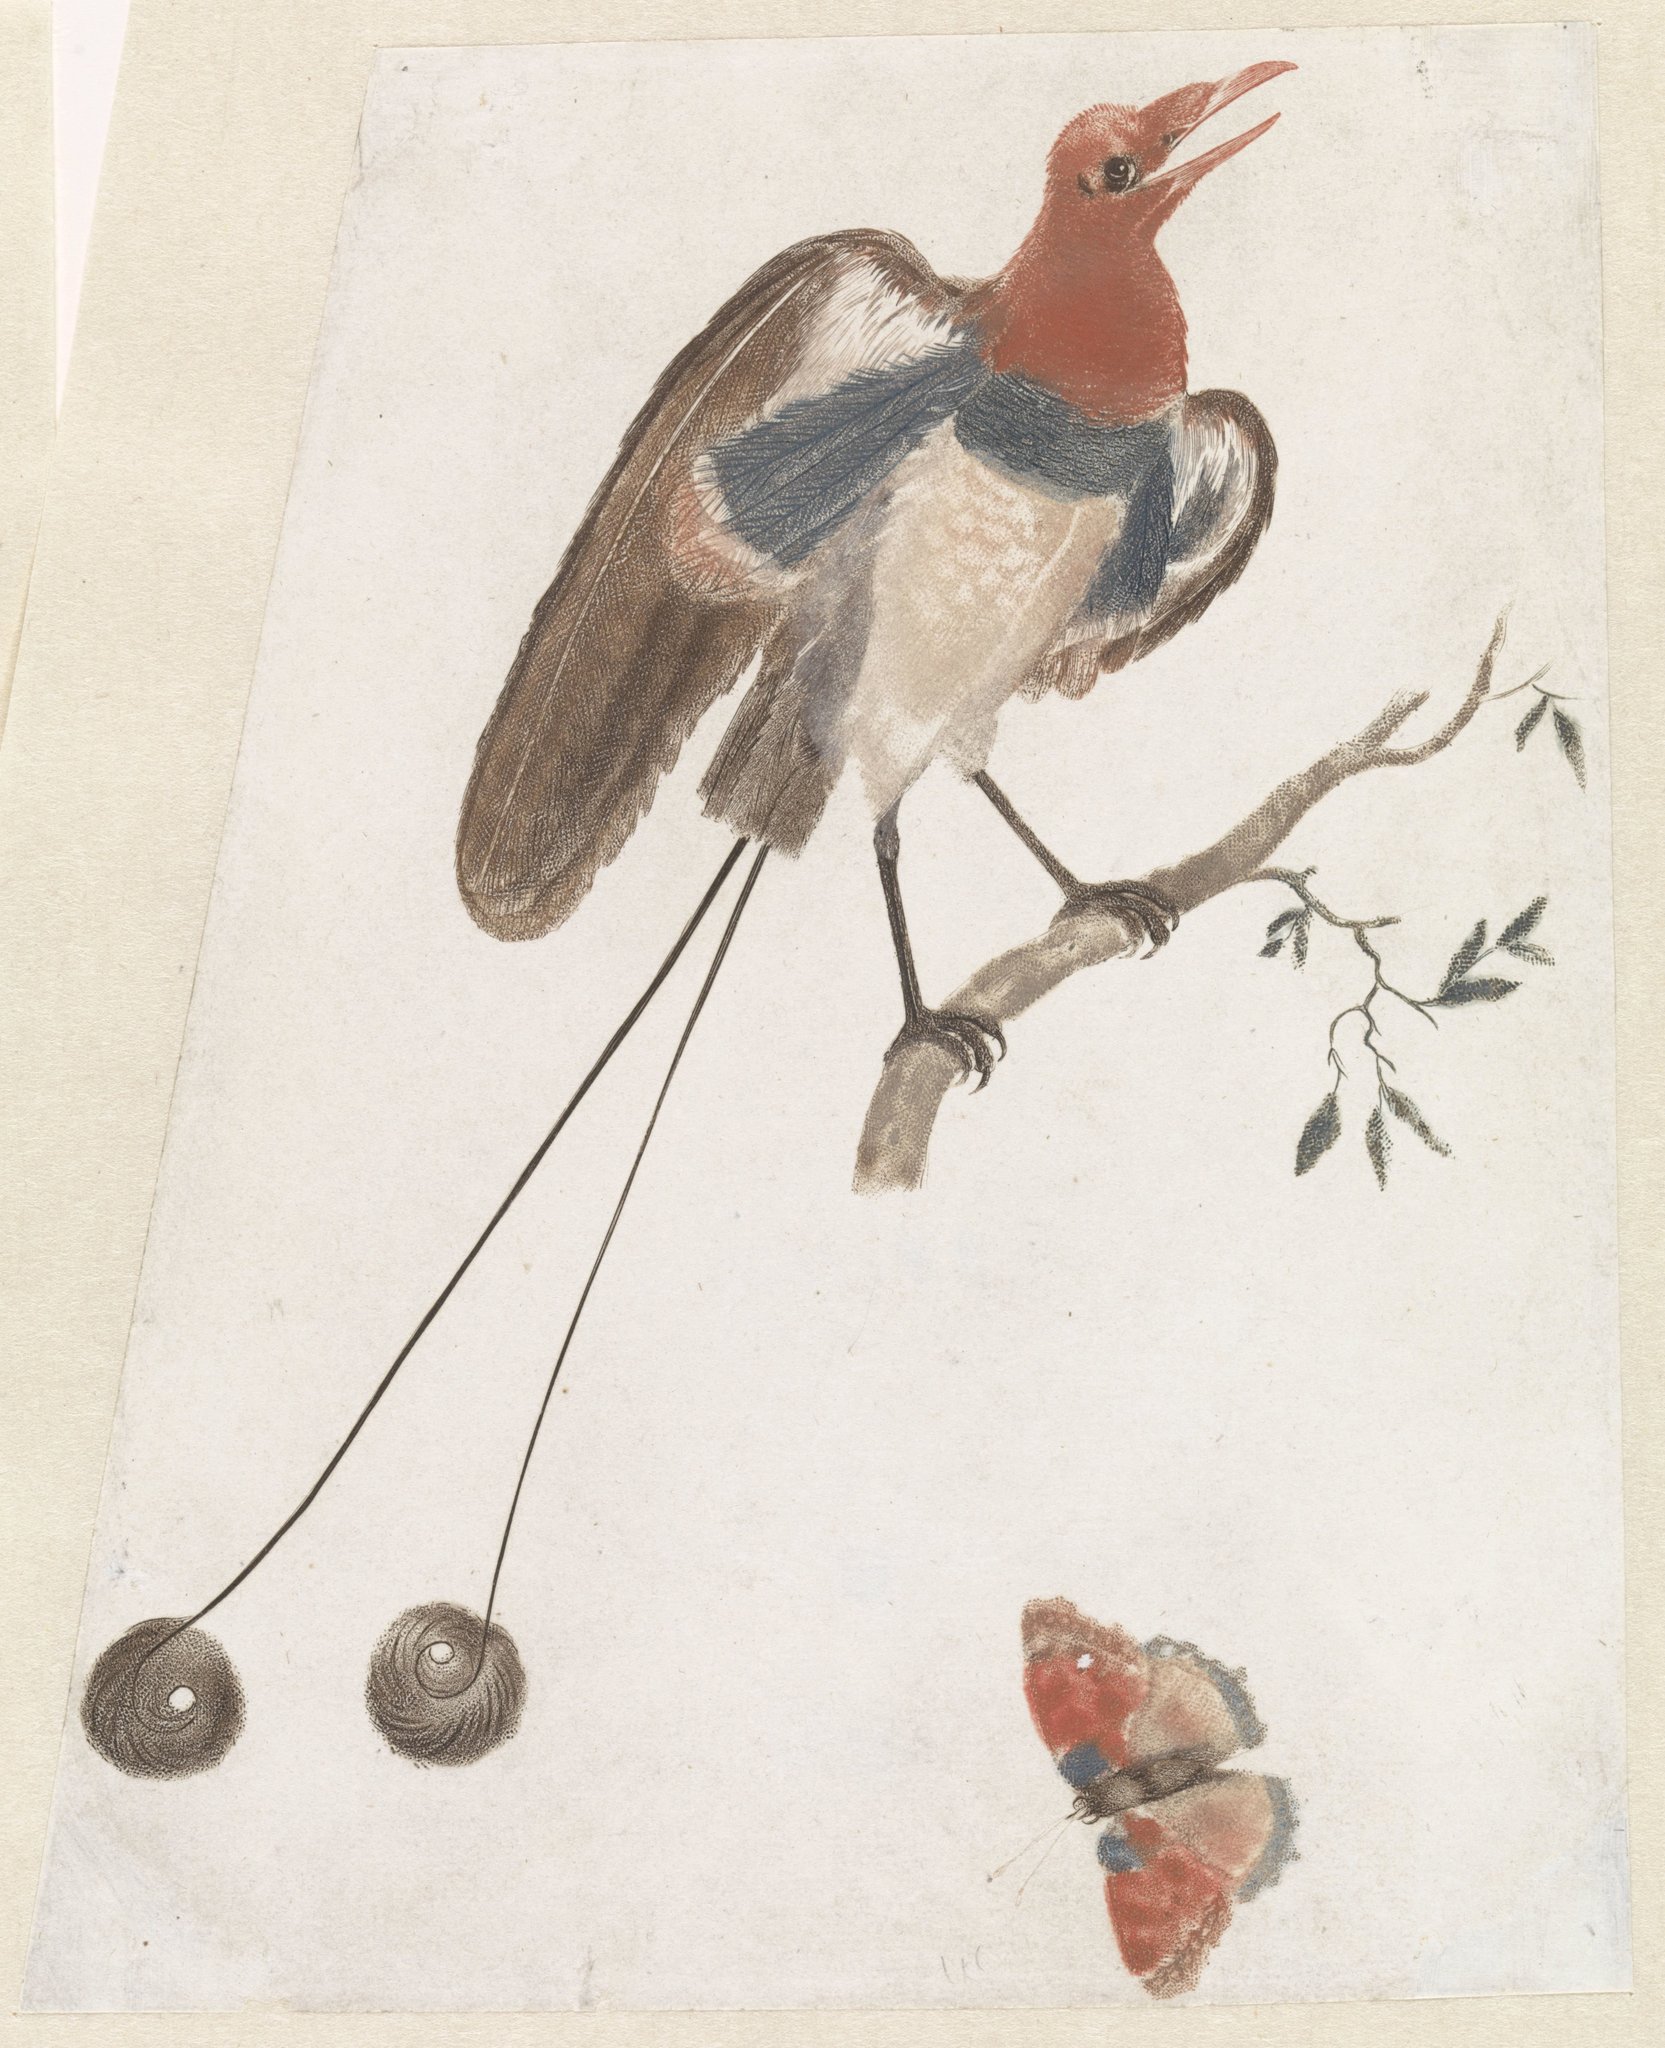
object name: print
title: Paradijsvogel en vlinder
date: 1688-1698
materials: paper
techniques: printing, engraving, lithography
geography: netherlands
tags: ornamental birds: bird of paradise, insects: butterfly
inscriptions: collector's mark: Lugt 2228, collector's mark: Lugt 2760